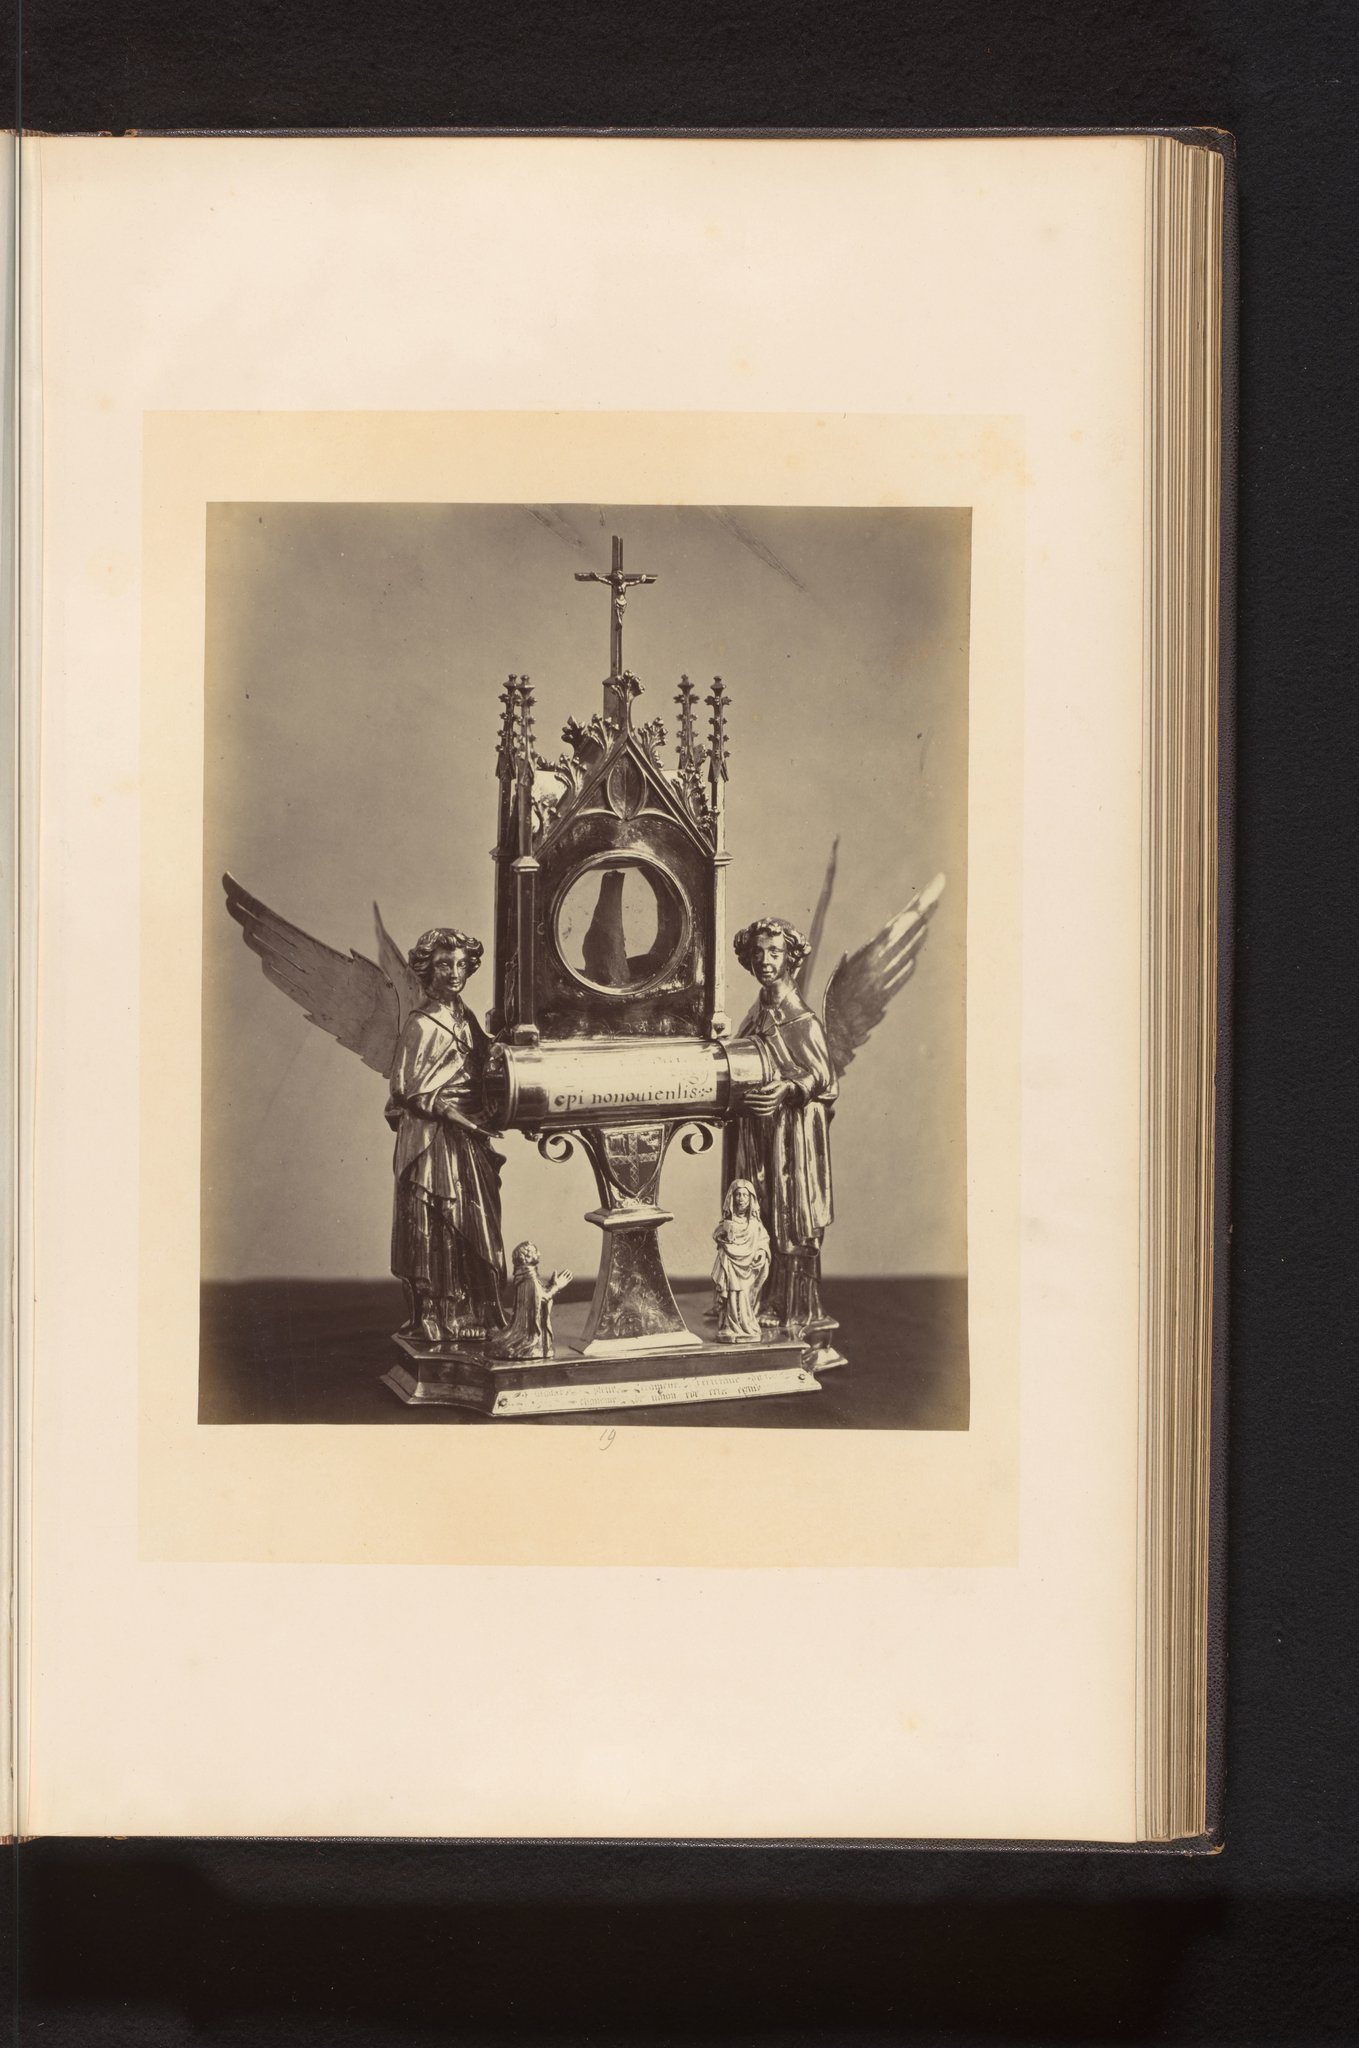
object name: photograph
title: Monstrans uit de Sint-Waltrudiskerk in Mons, opgesteld op een tentoonstelling over religieuze objecten uit de middeleeuwen en renaissance in 1864 in Mechelen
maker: joseph maes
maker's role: fotograaf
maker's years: 1838-1908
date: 1864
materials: photographic support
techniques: albumen print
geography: mechelen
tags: ostensorium, monstrance, relics (and reliquaries), mechelen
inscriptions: number: ‘19’